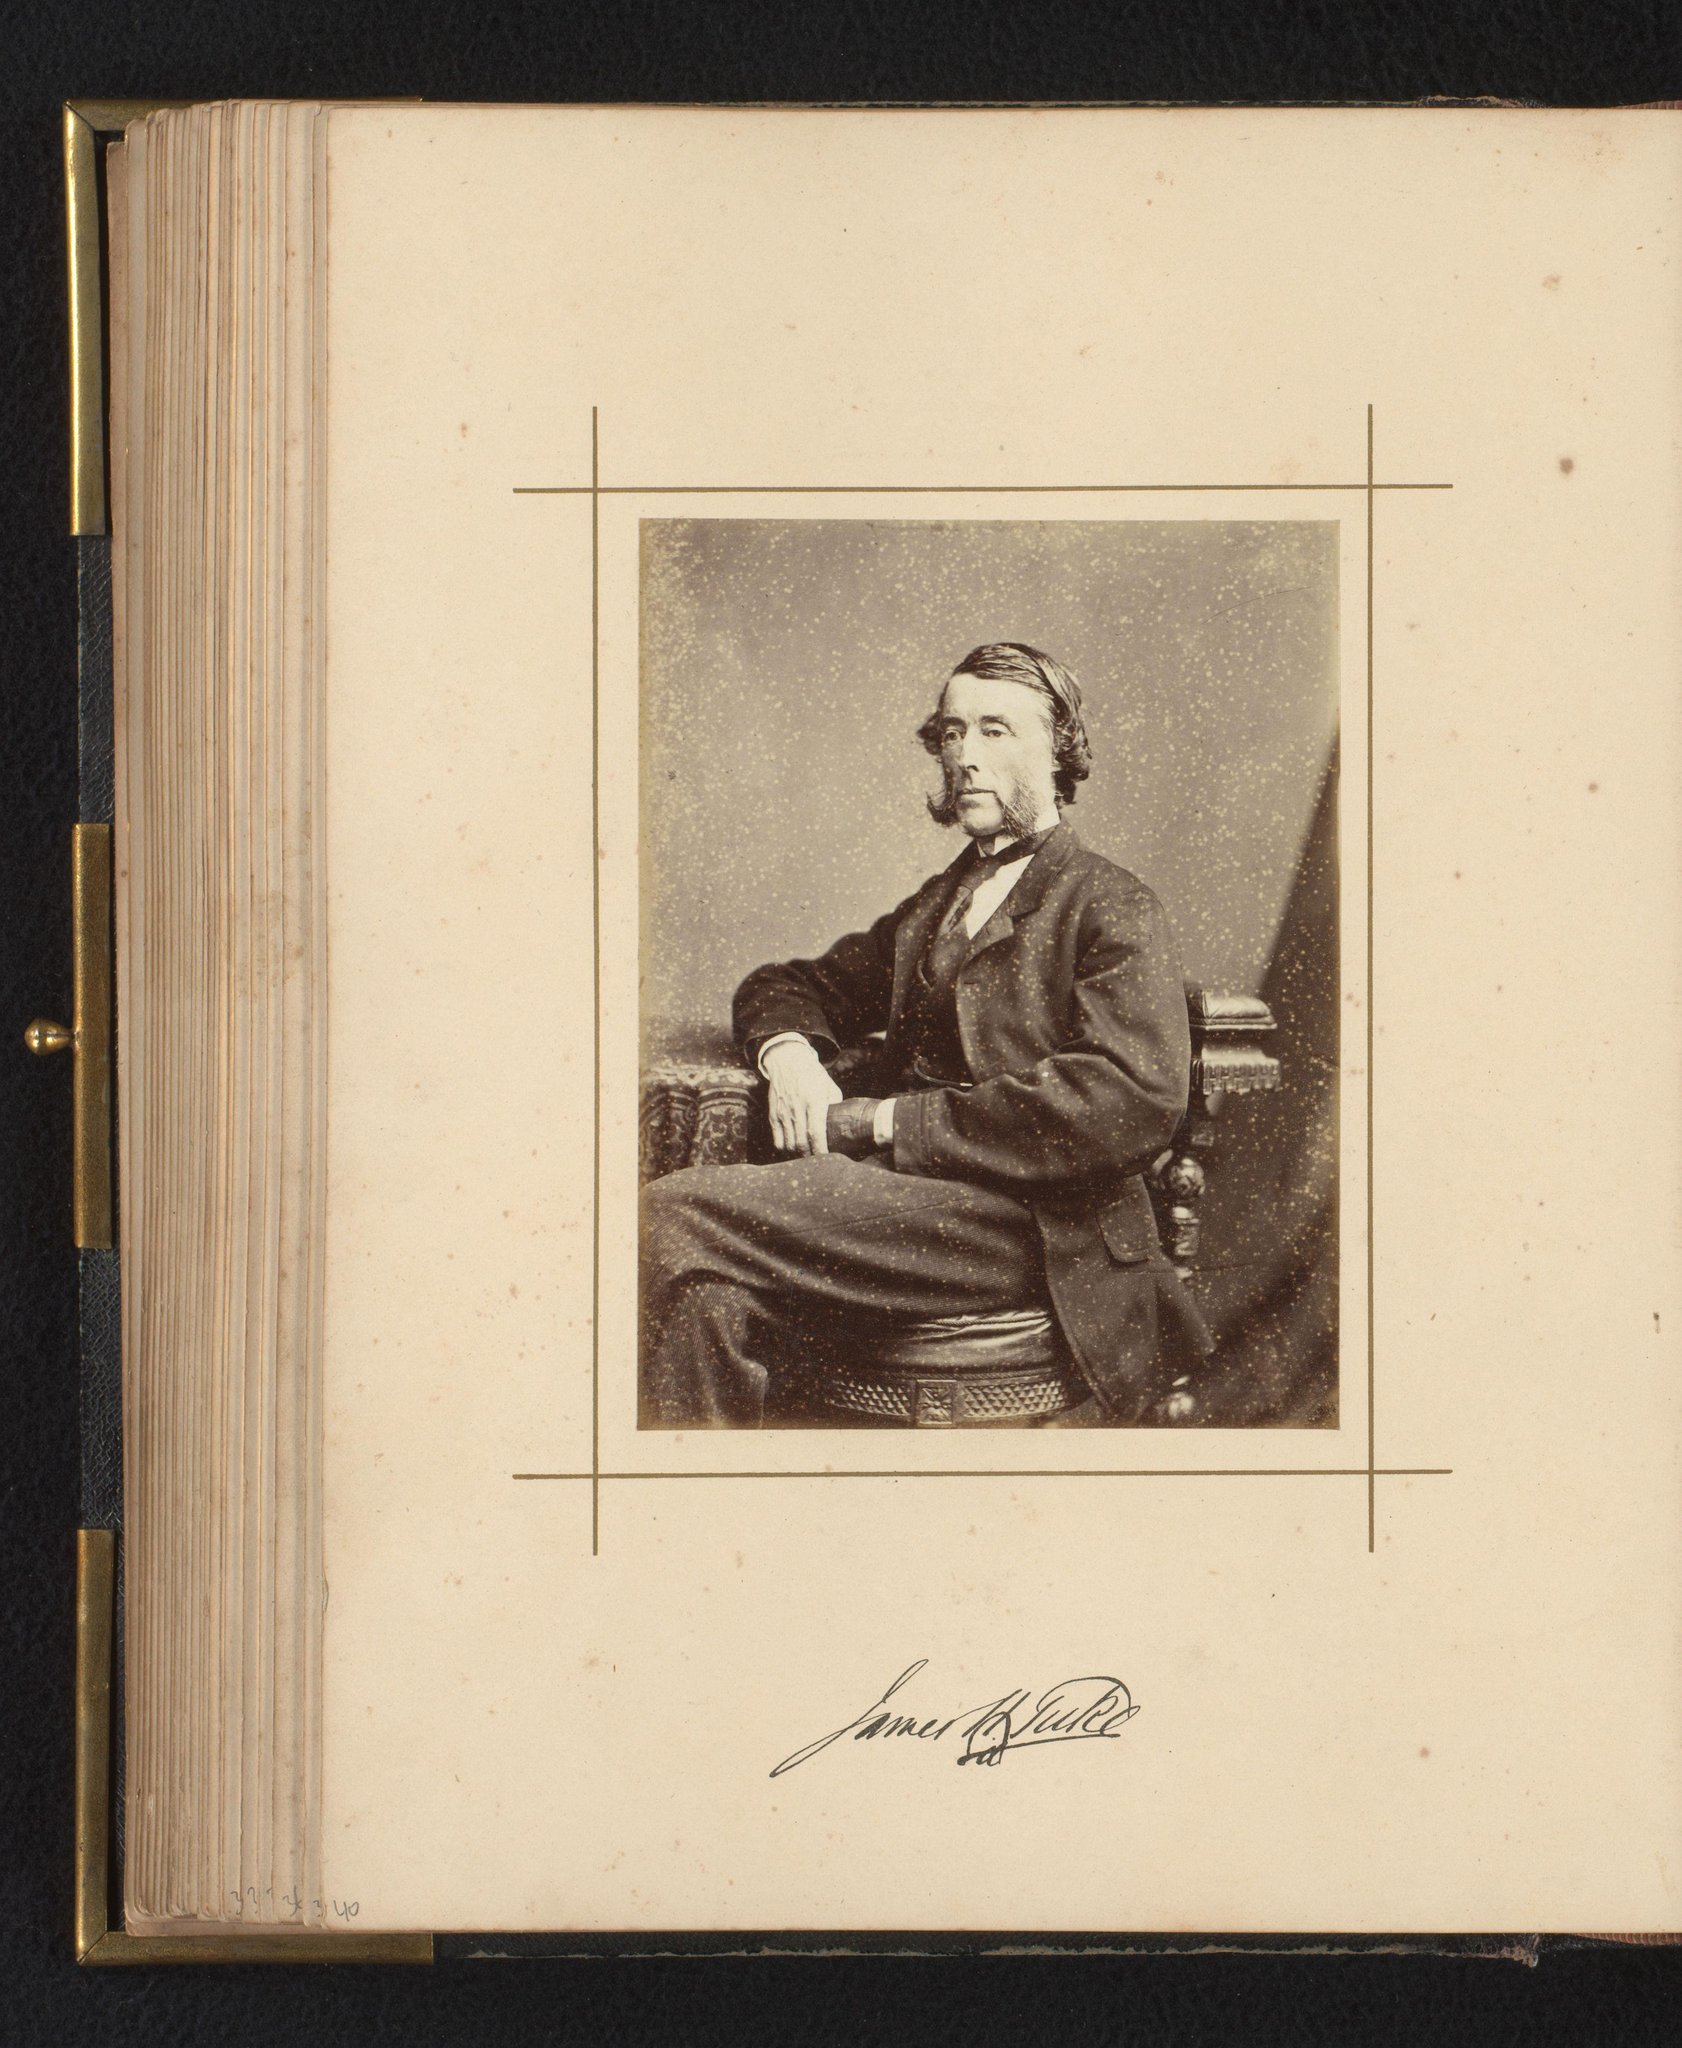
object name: page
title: Portret van een man, mogelijk James H. Duke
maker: Anonymous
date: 1866-1871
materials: photographic support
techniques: albumen print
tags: sitting figure, historical persons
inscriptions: name: ‘James [H. Duke]’